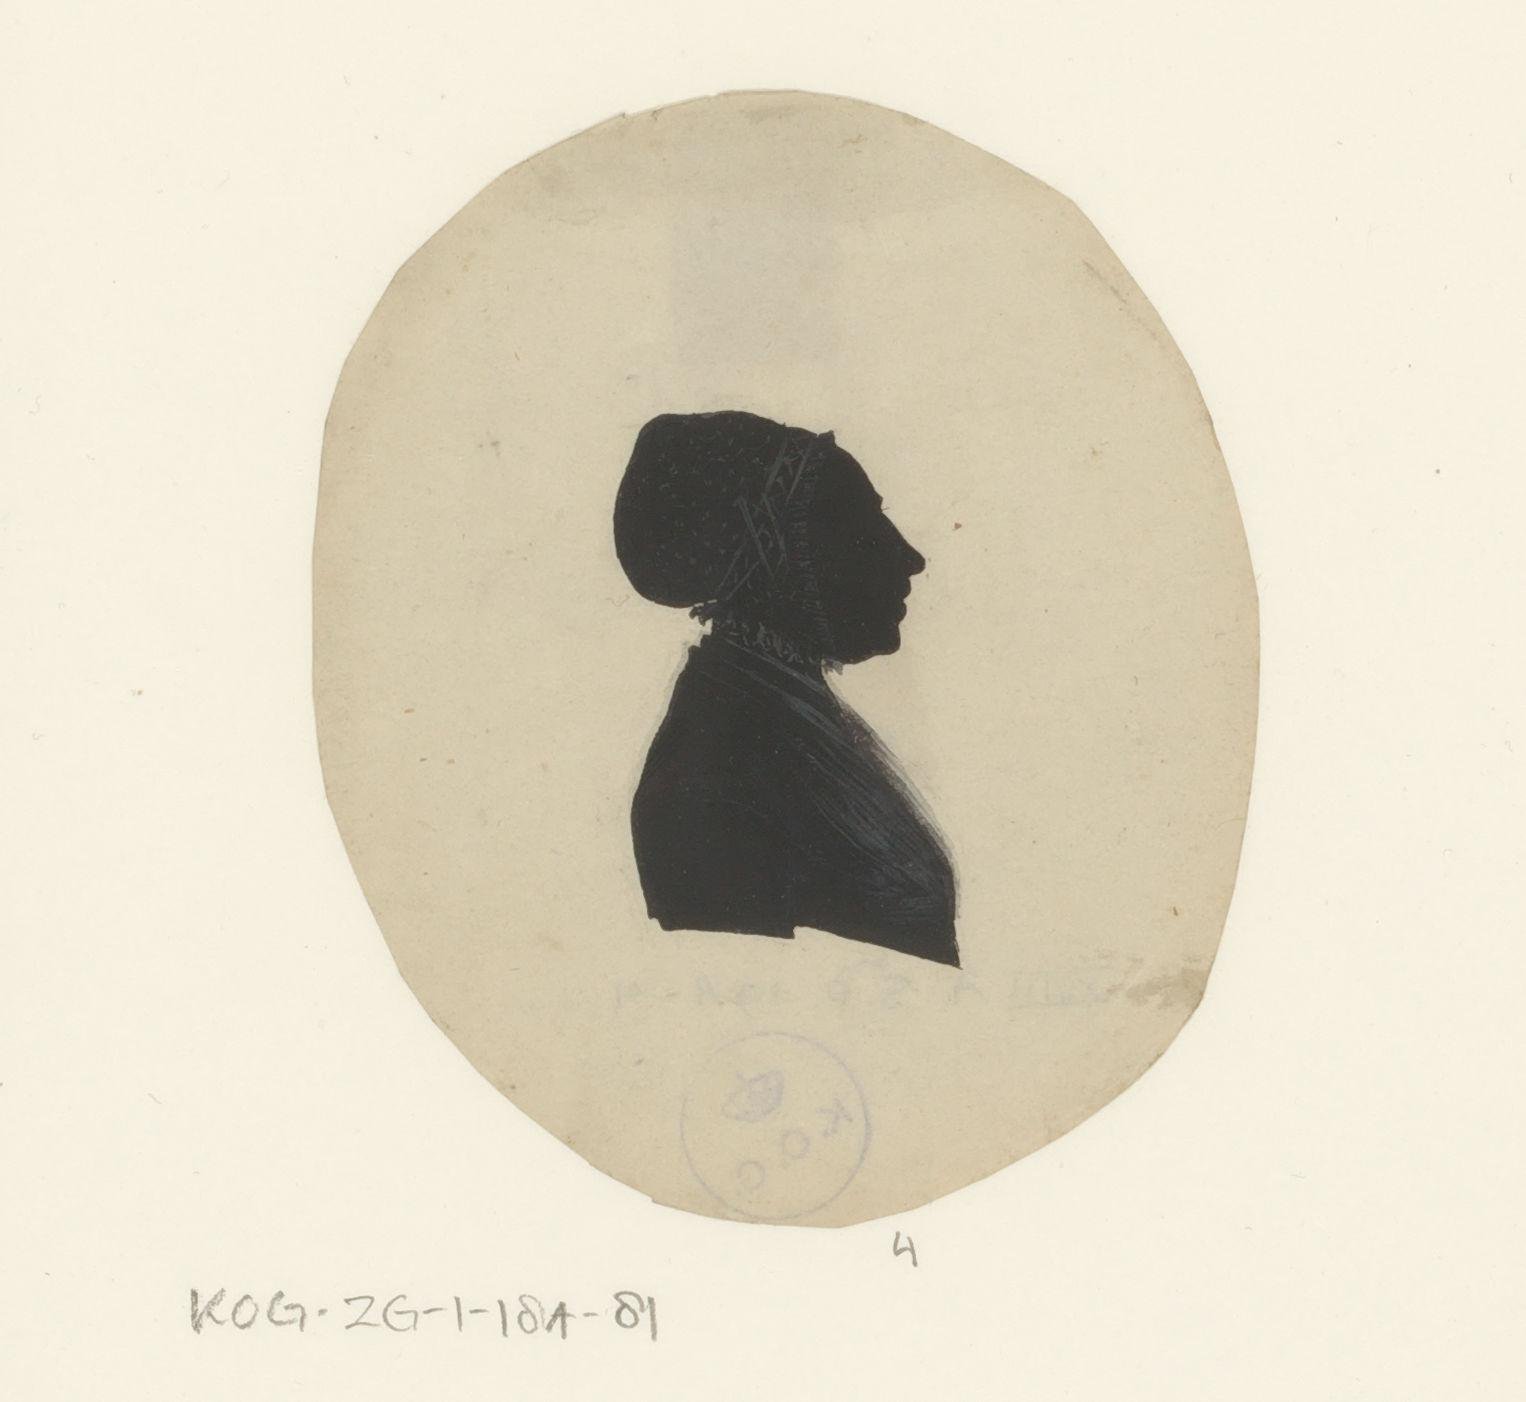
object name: silhouette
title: Silhouetportret van een onbekende vrouw met muts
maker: Anonymous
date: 1775-1849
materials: paint, paper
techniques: brush, pen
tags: historical persons not known by name - bb - woman, head-gear: cap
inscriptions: collector's mark: Lugt 1641, stamp, collector's mark: Lugt 1641a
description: Onderwerpsrubrieken binnen de Atlas Zeden en Gewoonten: Schoone kunsten, Silhouetportretten.